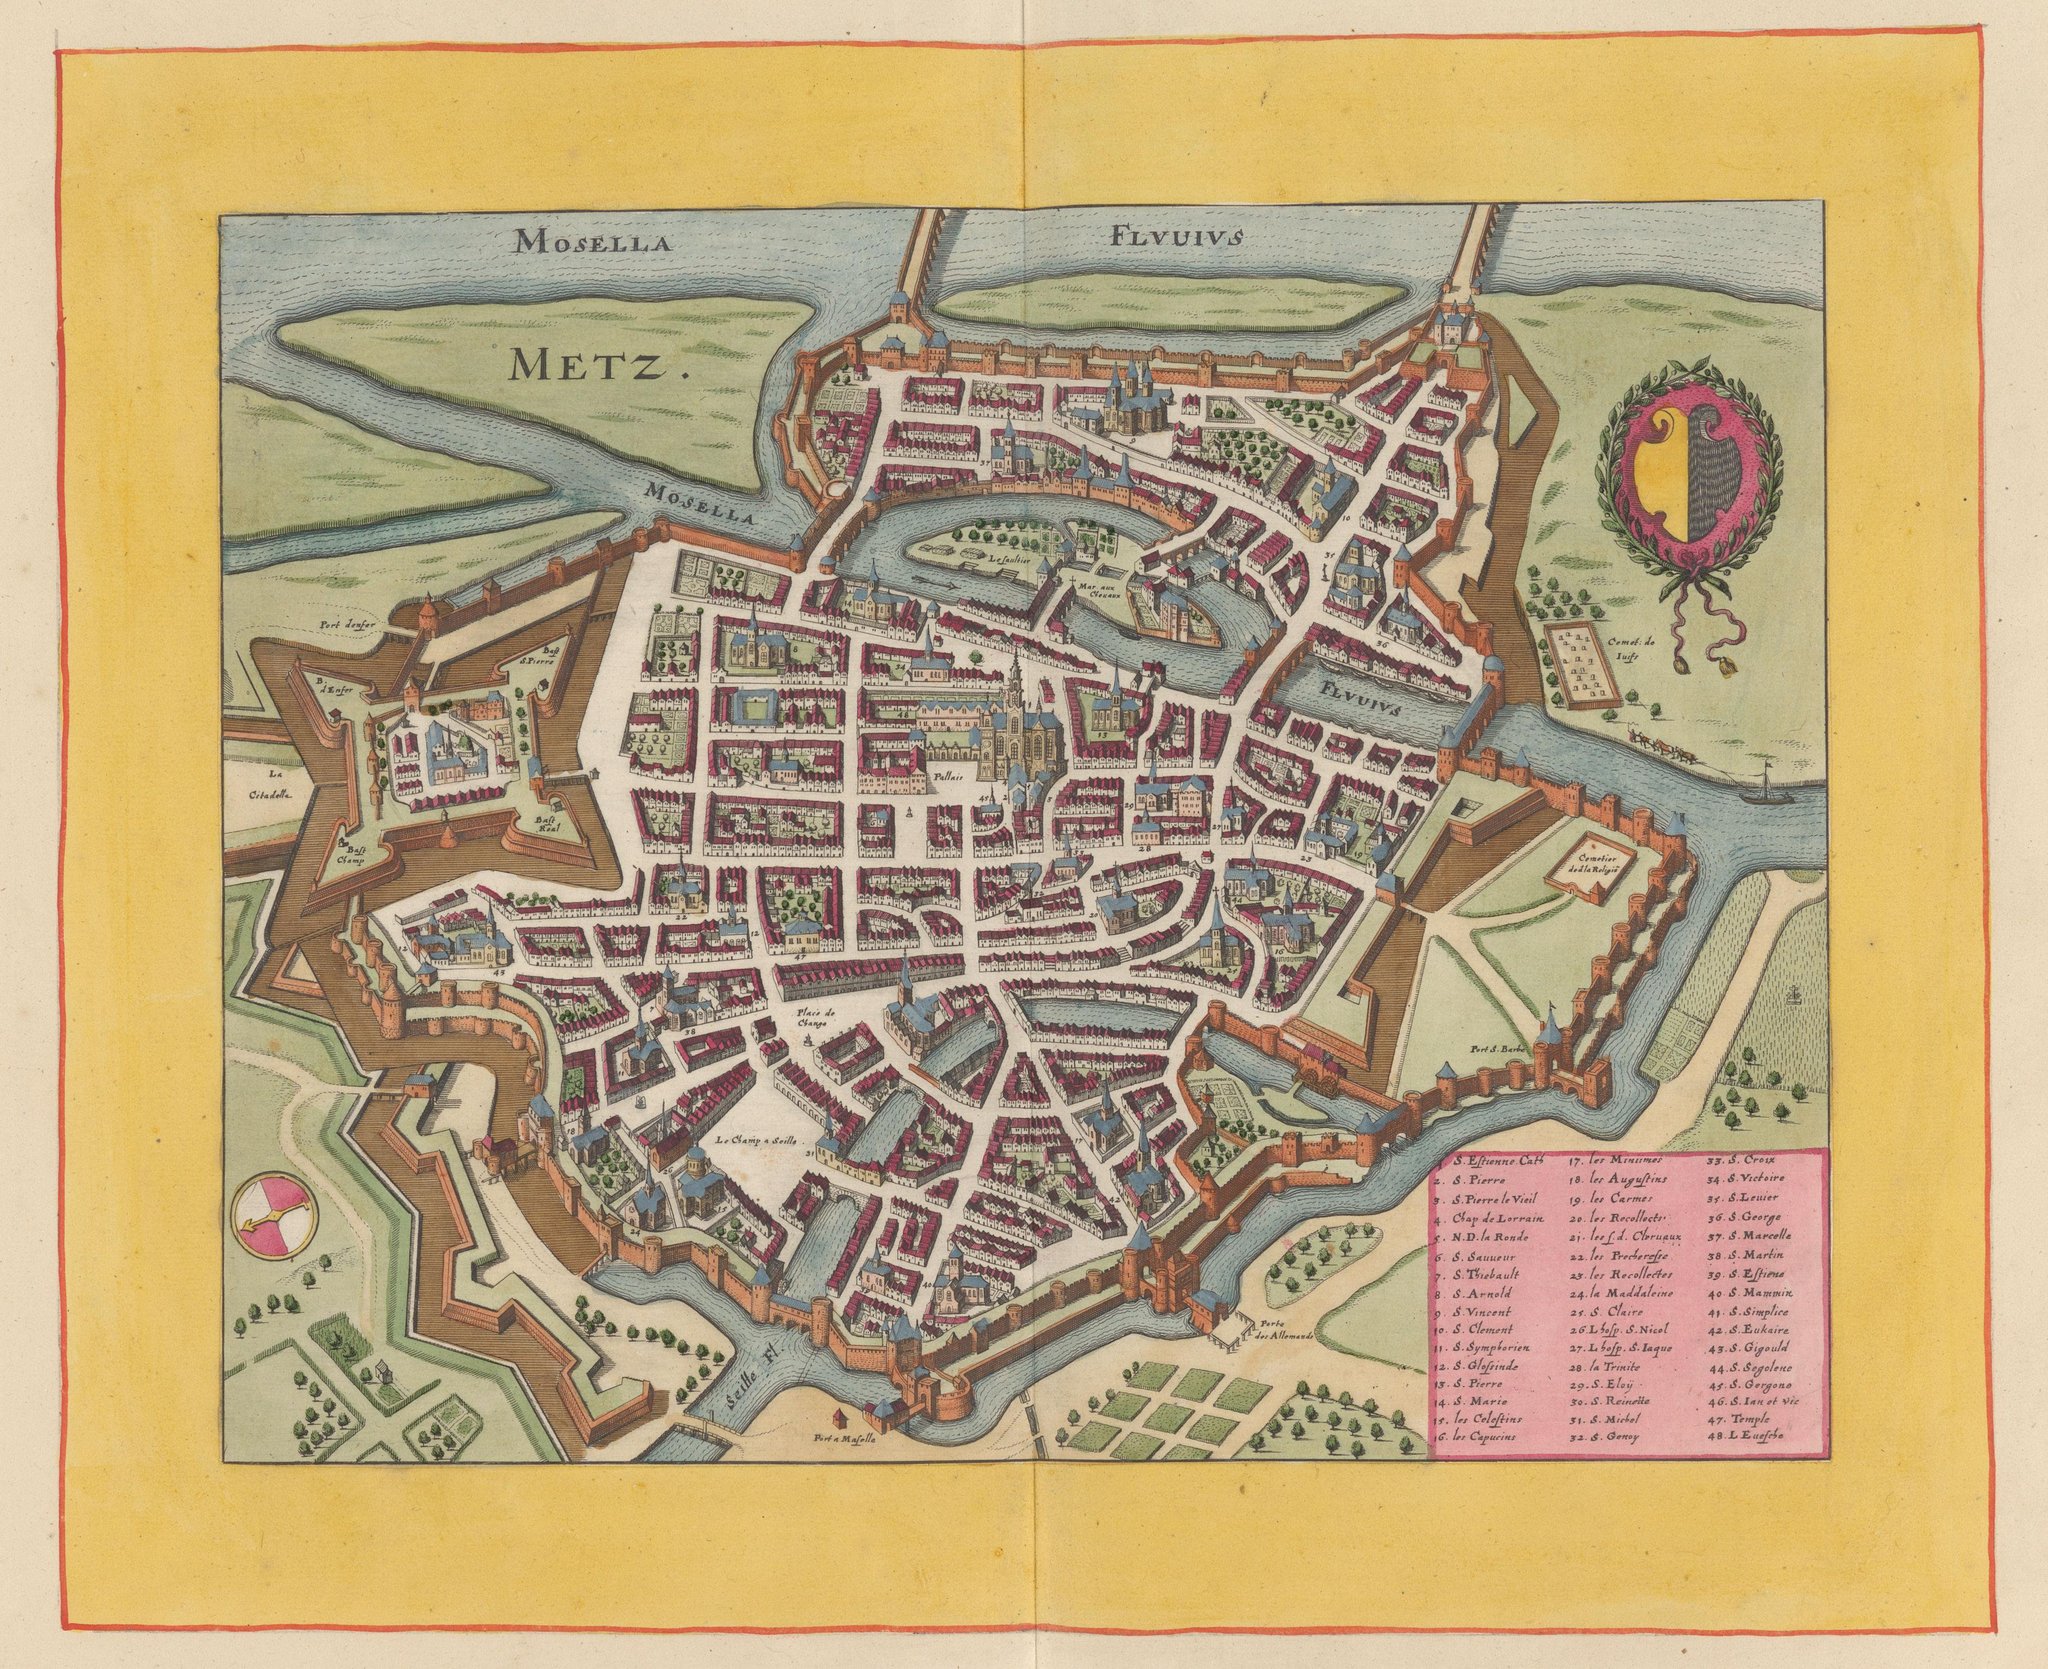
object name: area plan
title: Plattegrond van Metz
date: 1656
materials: paper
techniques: engraving, etching, hand coloring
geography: the hague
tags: maps of cities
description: Prent uit: Zeiller, Martin. Topographia Galliae. 13 dln. Frankfurt: Caspar Merian, 1656, dl. 3, na p. 20.